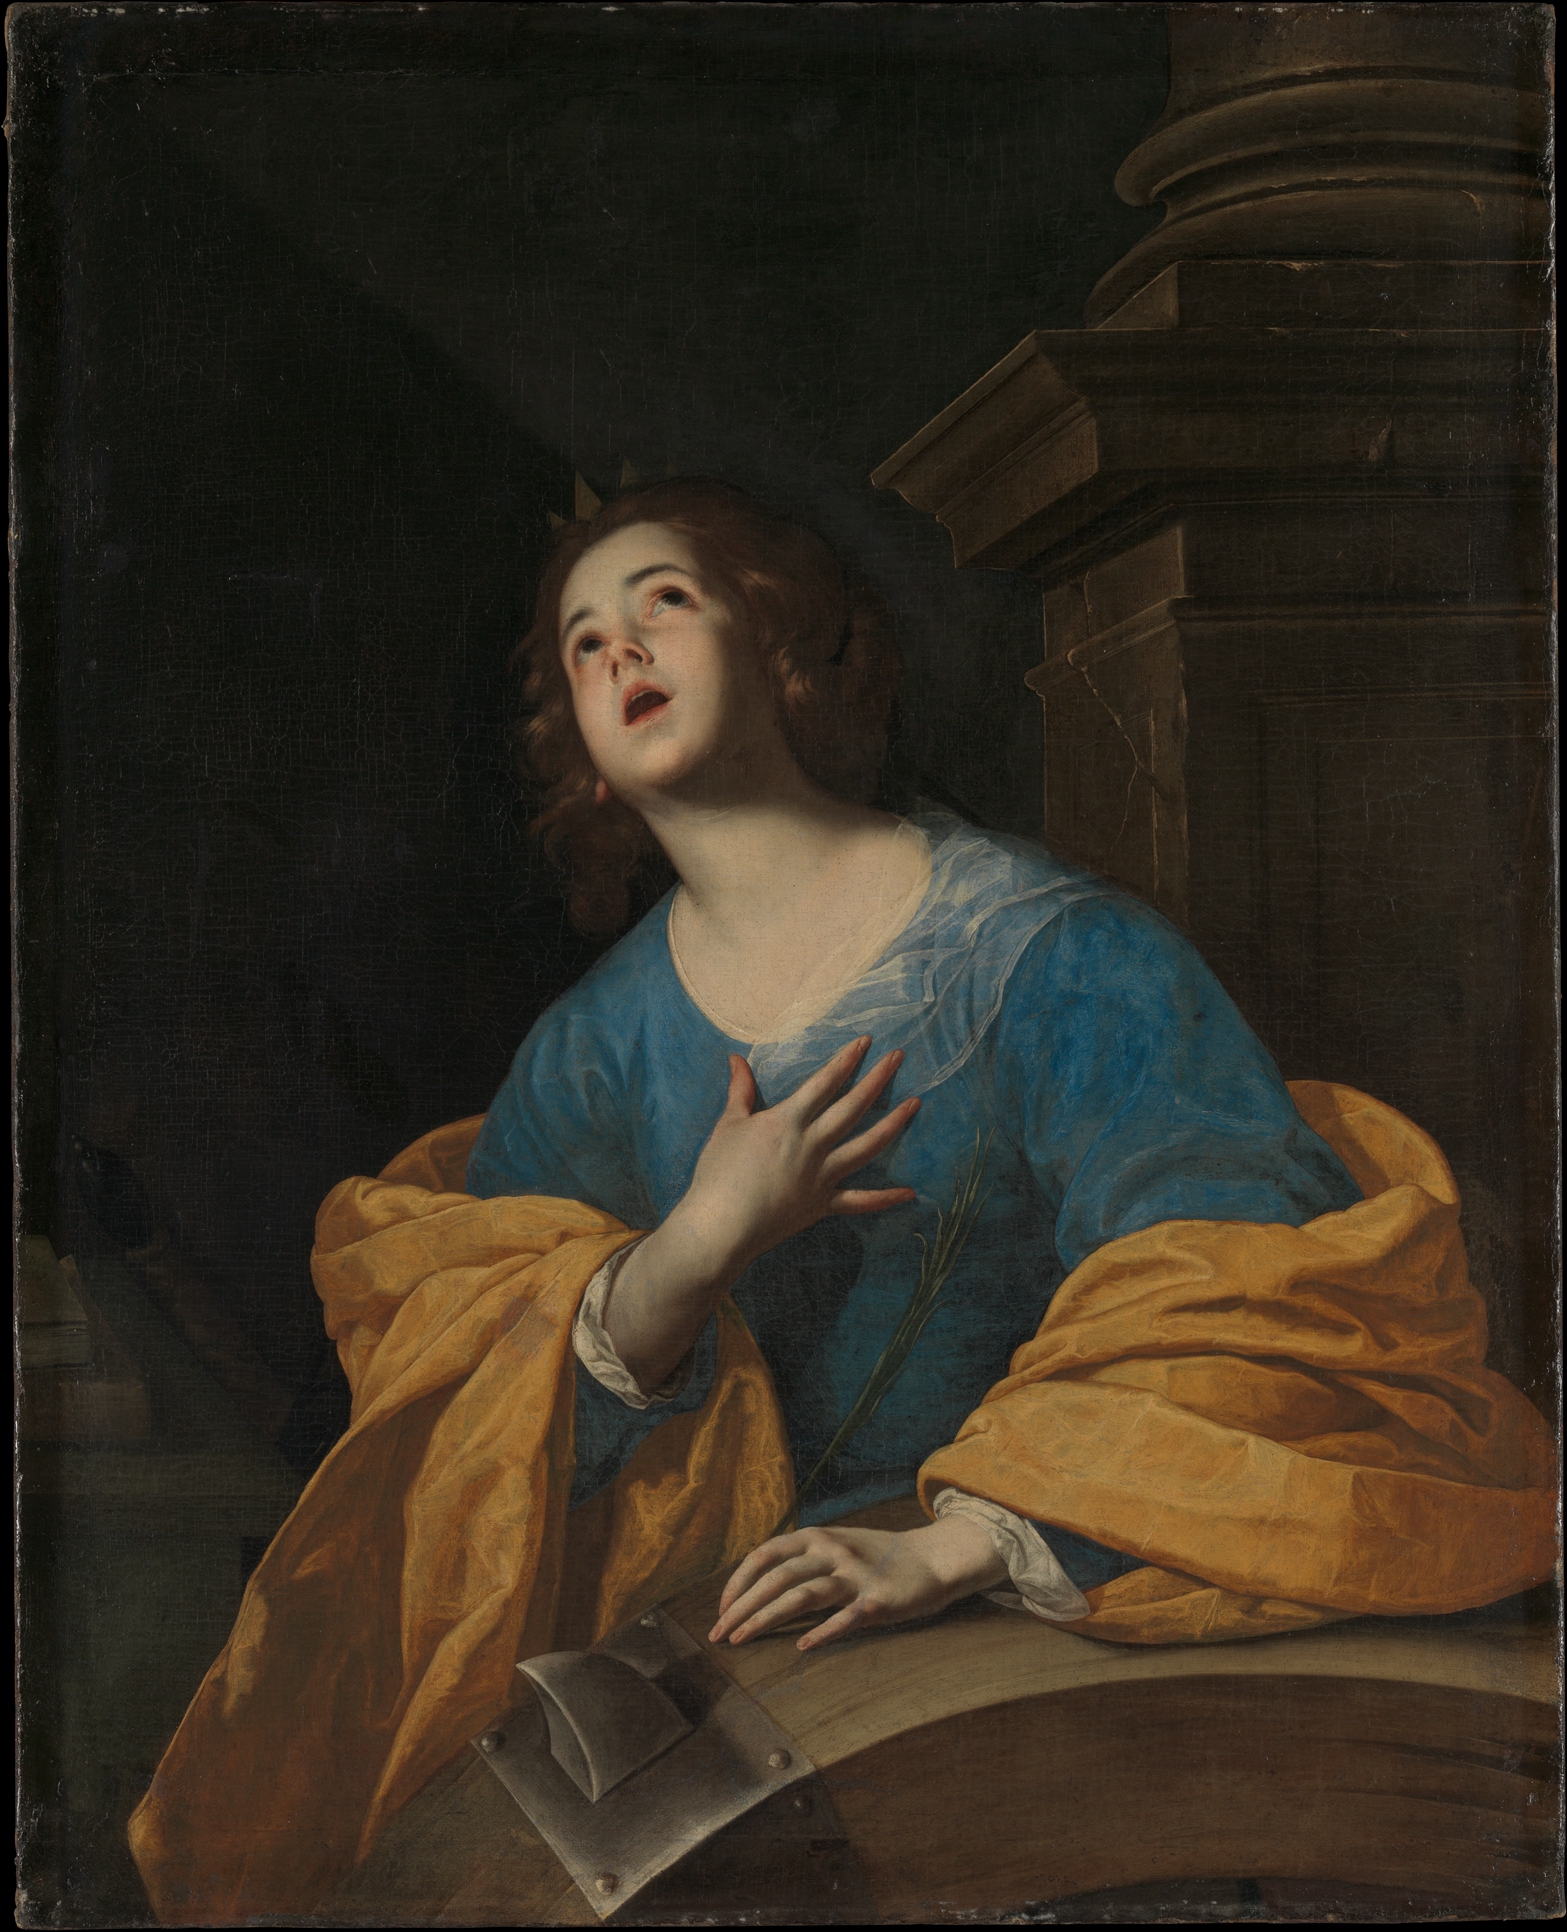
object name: painting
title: Saint Catherine of Alexandria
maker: bernardo cavallino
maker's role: artist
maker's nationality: italian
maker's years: 1616-1656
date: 1636-1654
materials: canvas, oil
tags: women,saint catherine